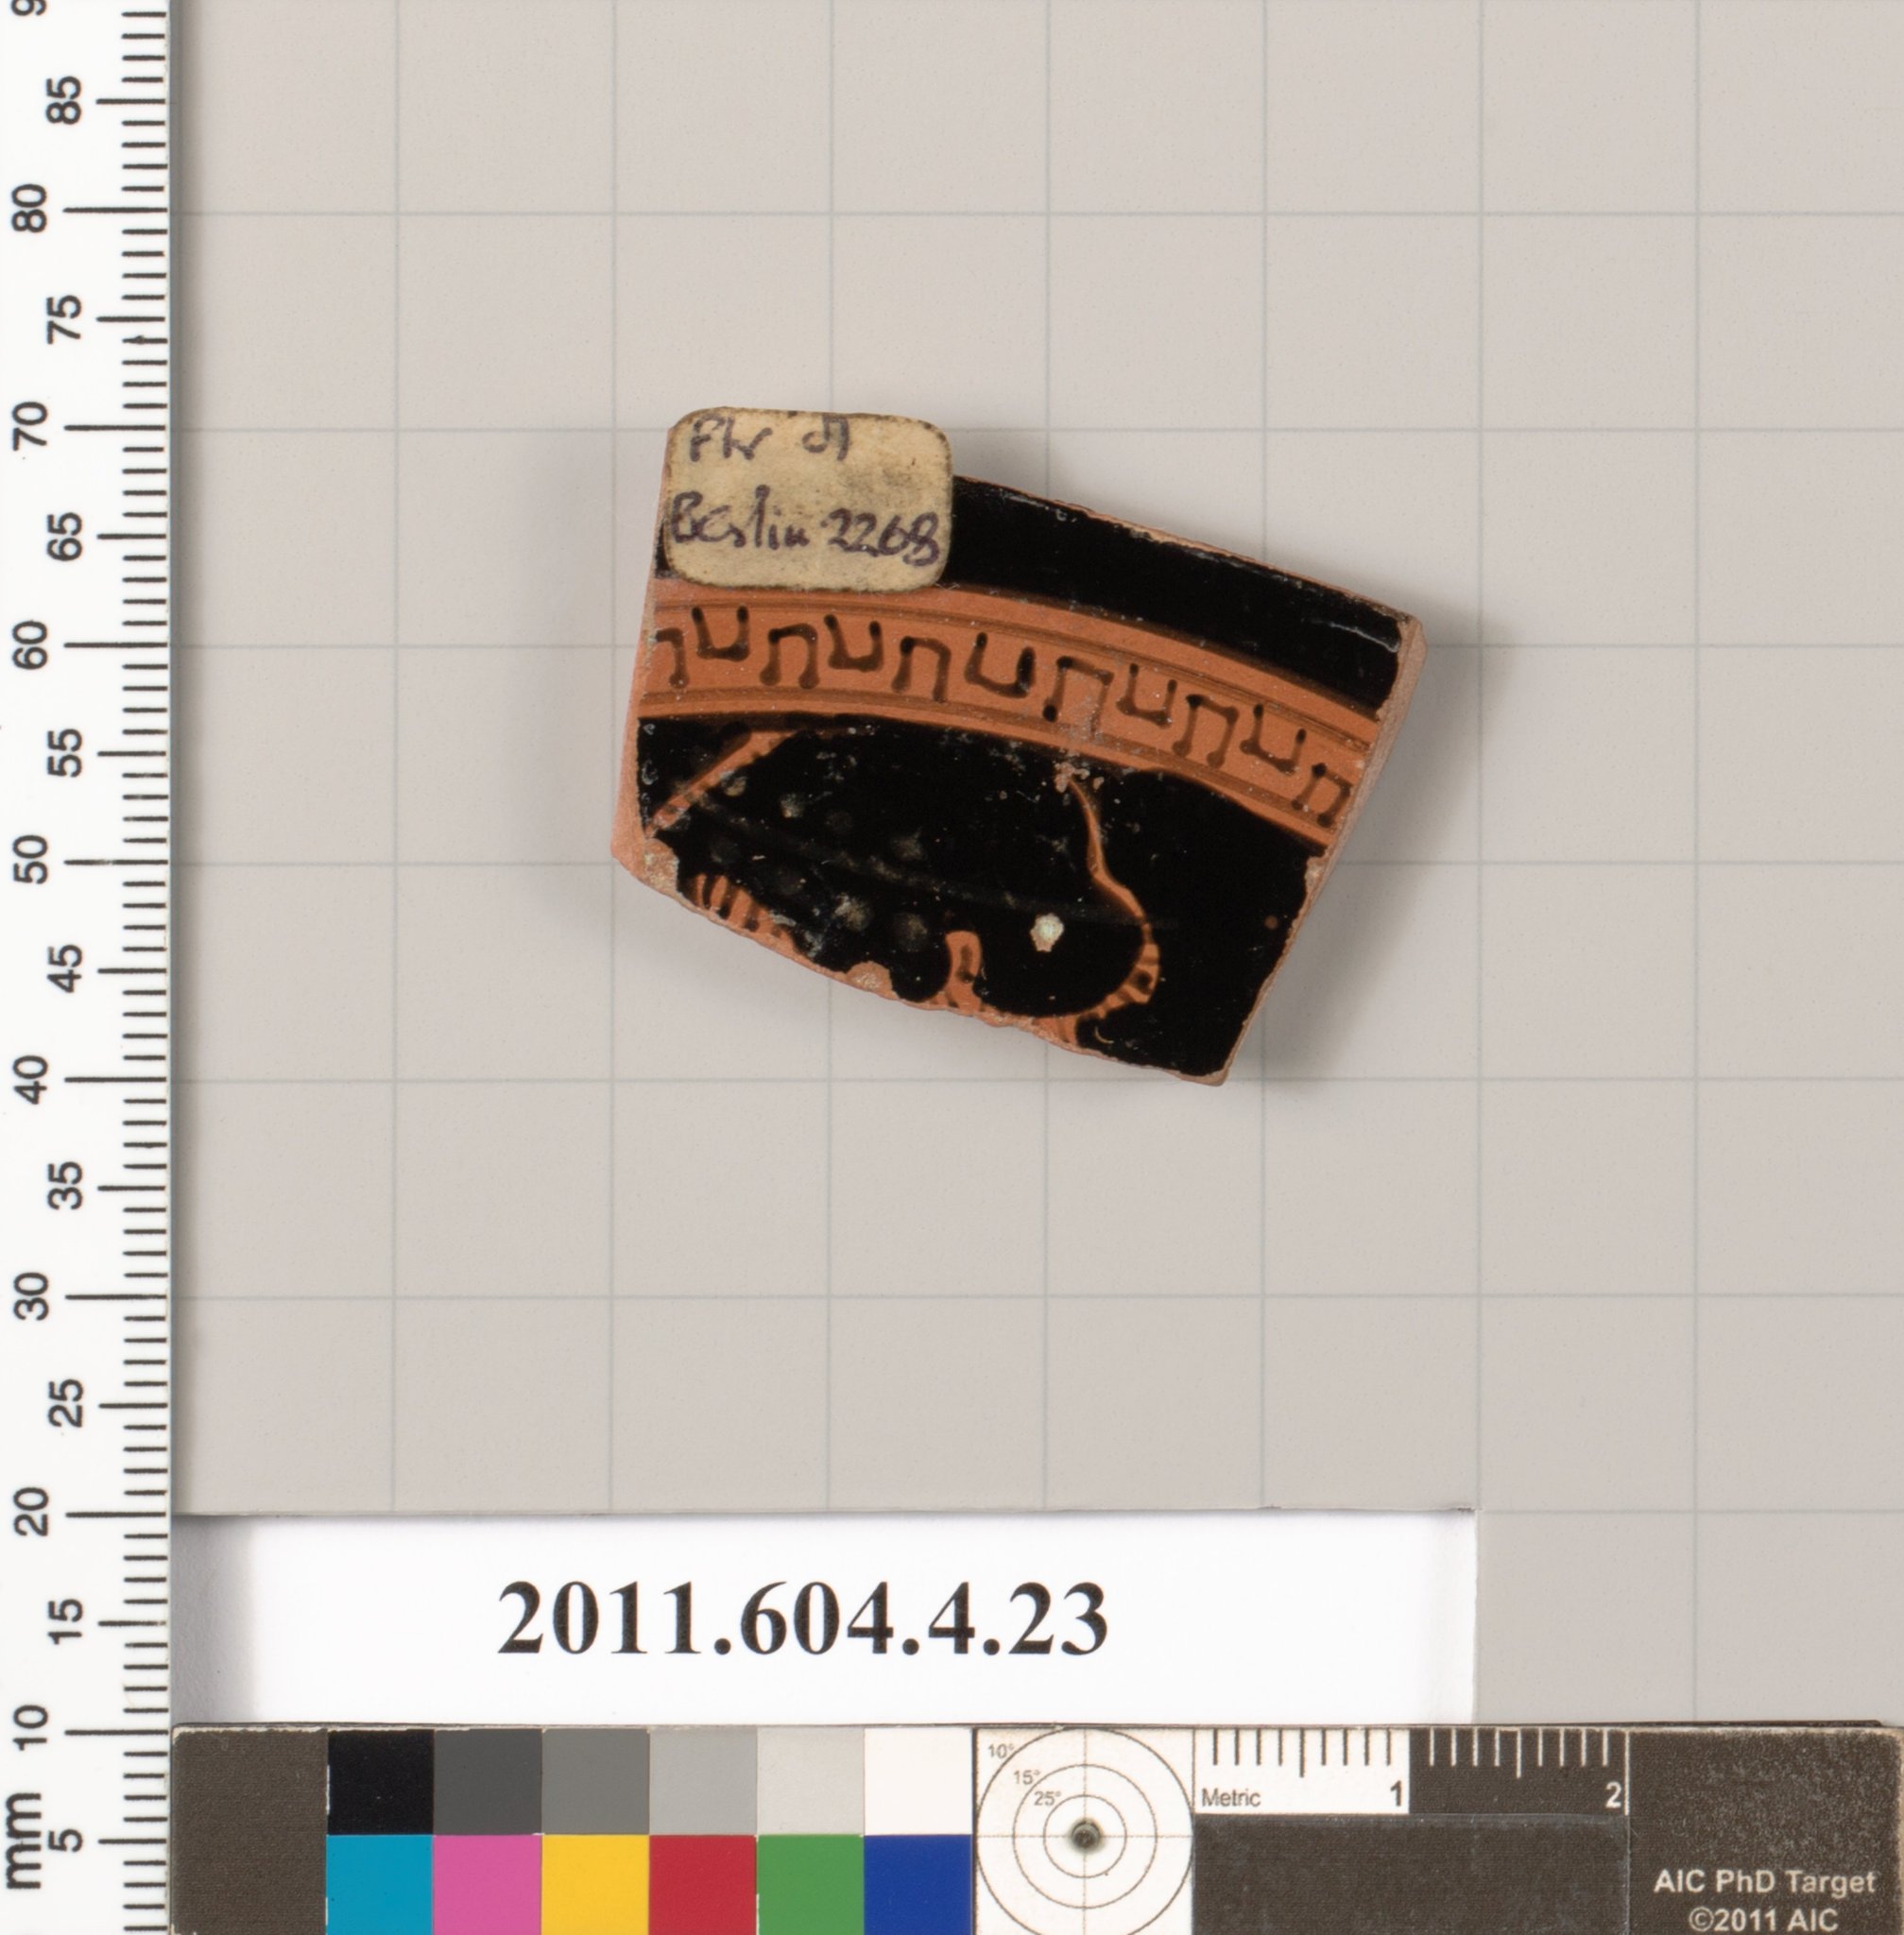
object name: kylix fragment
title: Terracotta fragment of a kylix (drinking cup)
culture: greek, attic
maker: painter of berlin 2268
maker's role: artist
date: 525-501 BCE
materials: terracotta